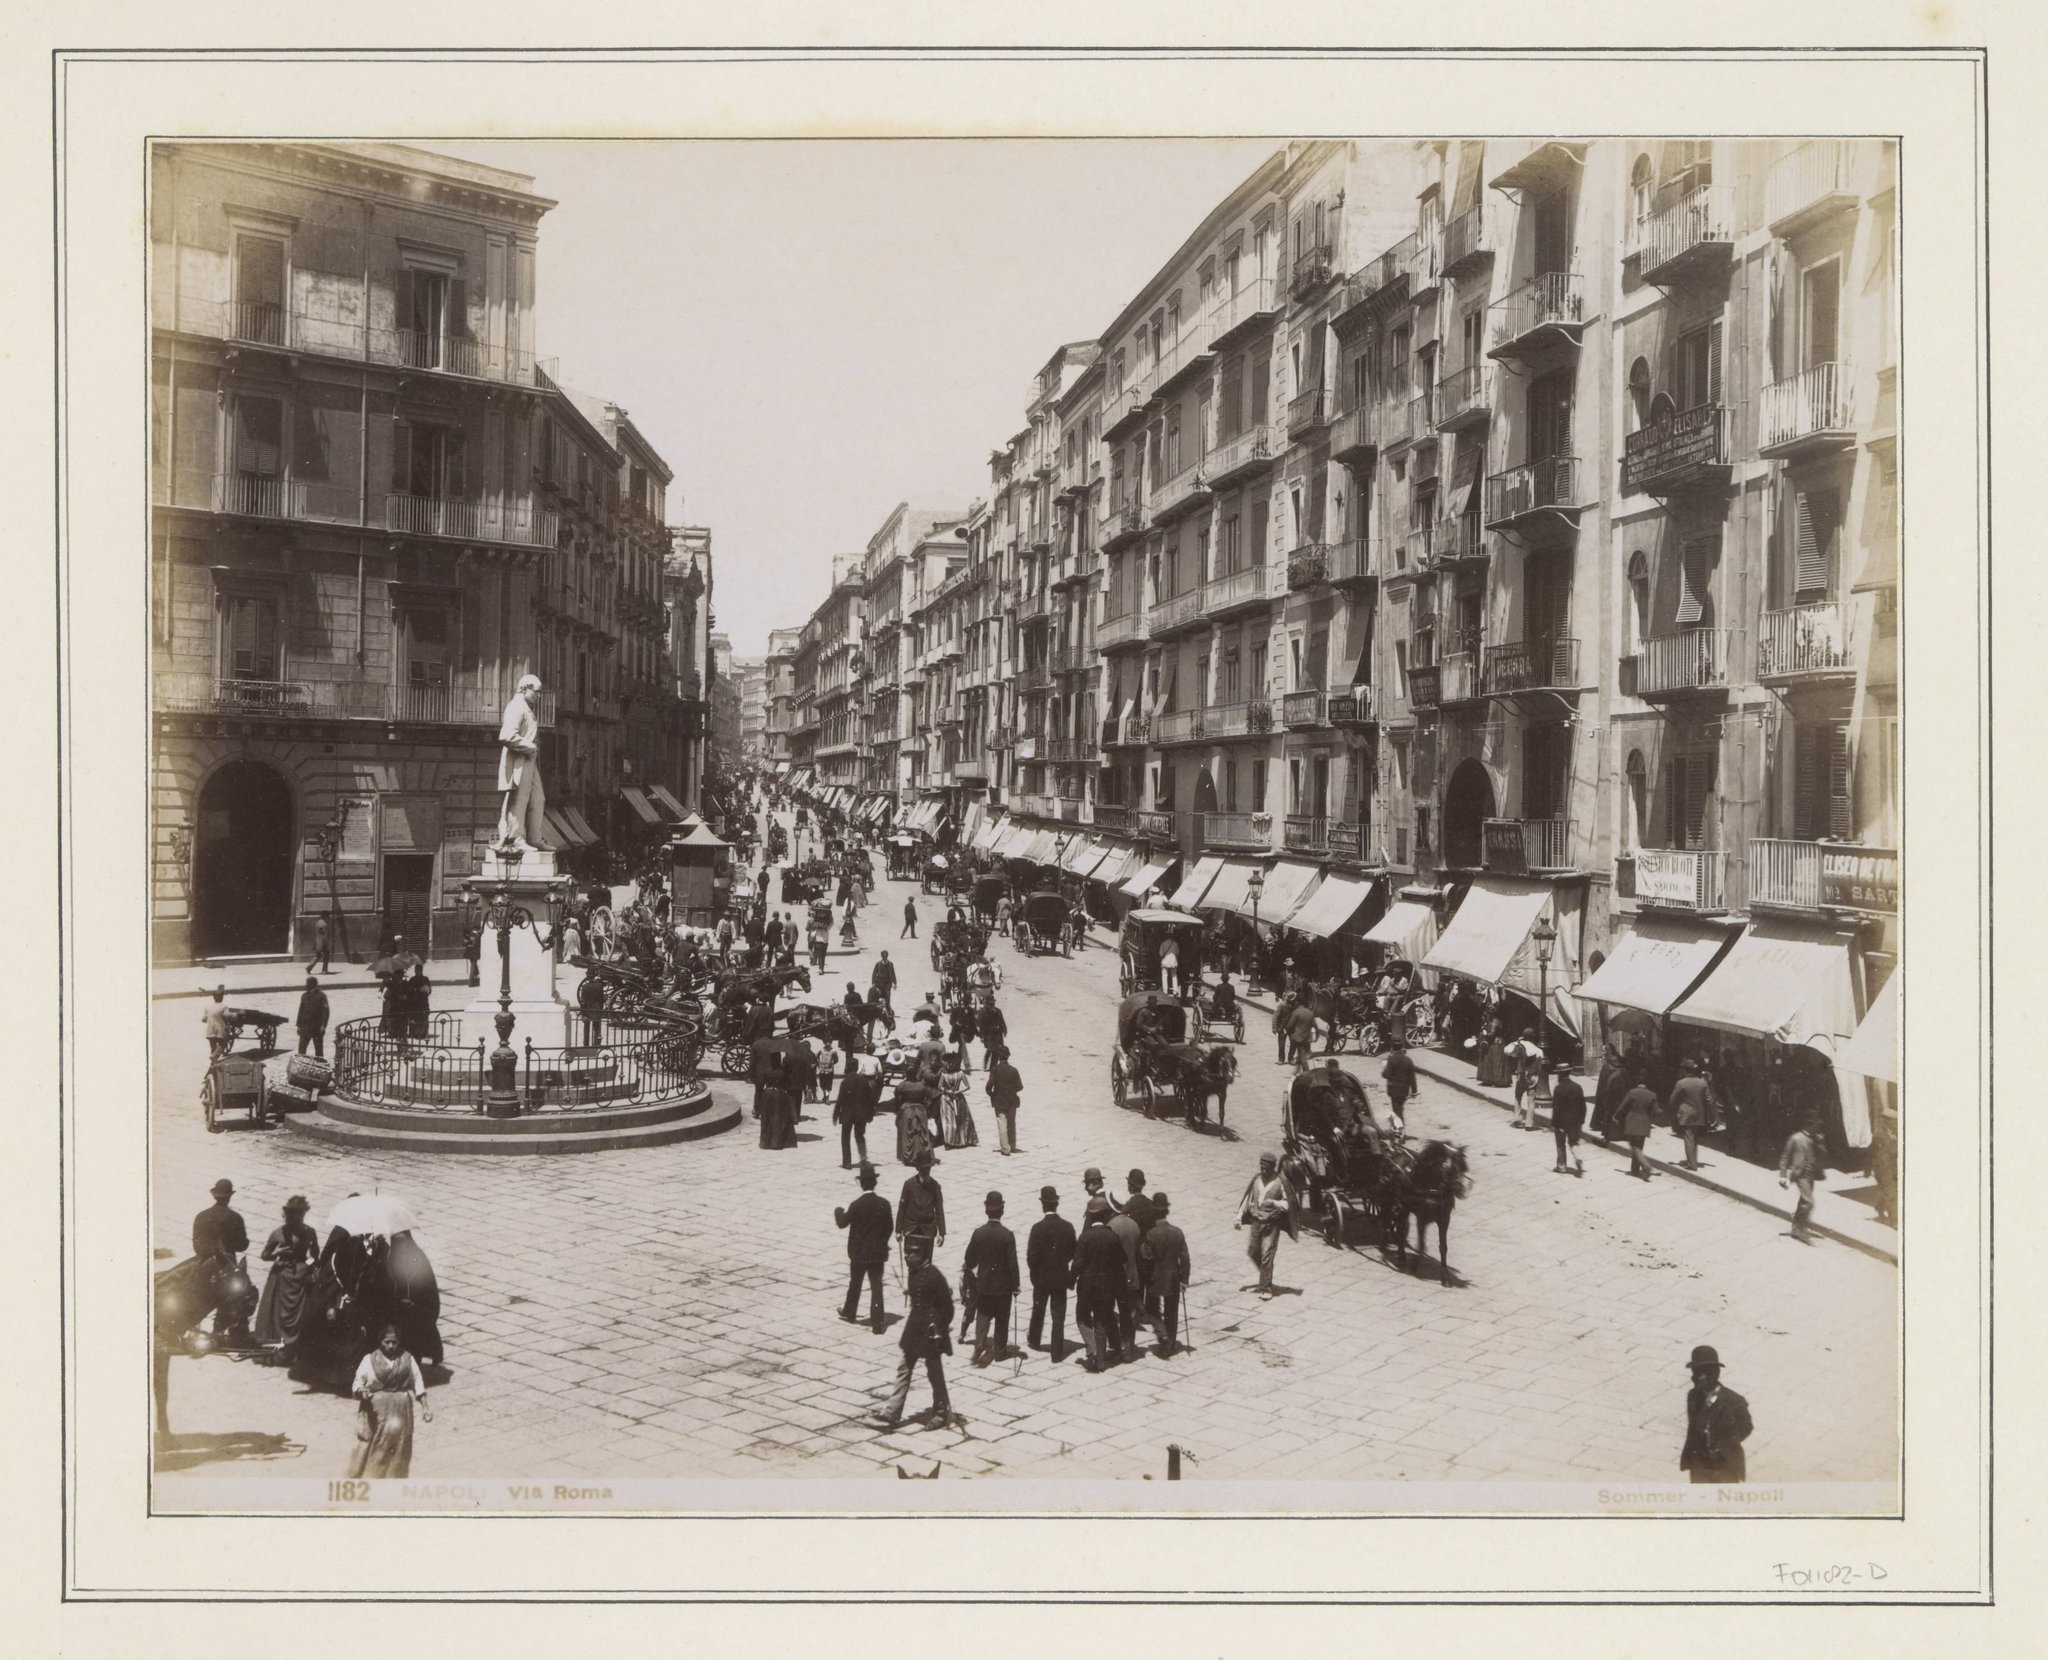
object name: photograph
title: Gezicht op de Via Roma in Napels met een standbeeld, winkels, paardenkoetsen en voorbijgangers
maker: giorgio sommer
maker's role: fotograaf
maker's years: 1834-1914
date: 1860-1890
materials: paper, photographic support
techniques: albumen print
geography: naples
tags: shop, store, four-wheeled, animal-drawn vehicle, e.g.: cab, carriage, coach (+ conveyance for transport of persons), street (+ city(-scape) with figures, staffage), naples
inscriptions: negative number: ‘1182’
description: Onderdeel van Reisalbum met foto's van bezienswaardigheden in Italië en aan de Franse Rivièra (deel II).